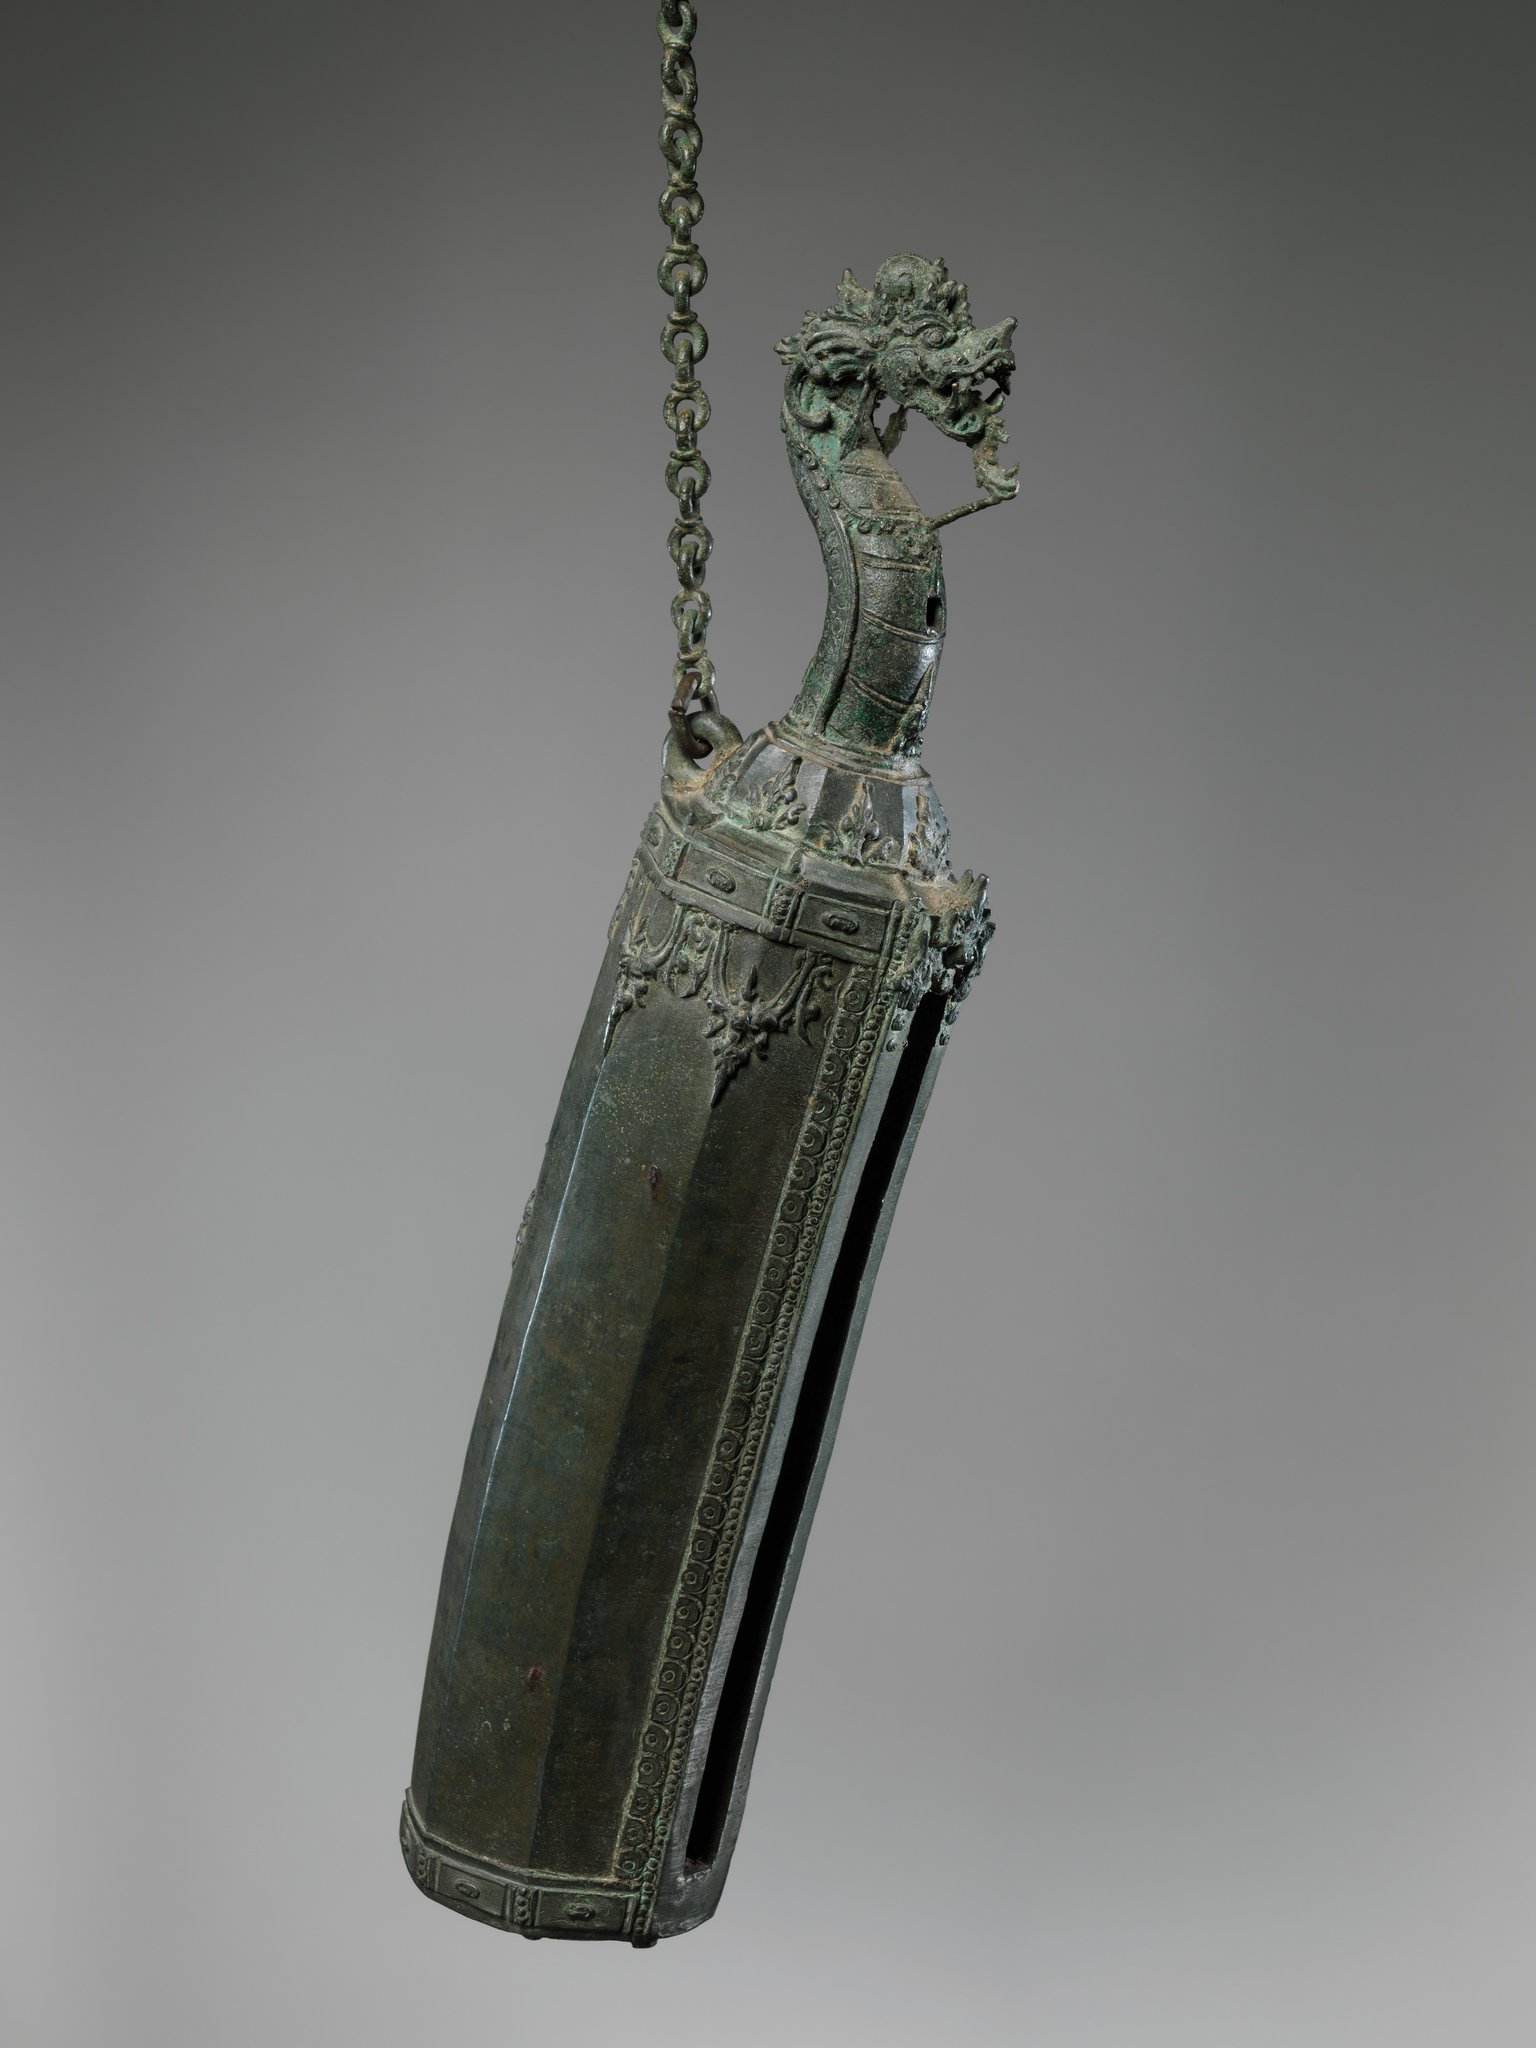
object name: slit gong kentongan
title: Slit Gong (Kentongan)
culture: indonesian, javanese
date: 1201-1300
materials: bronze